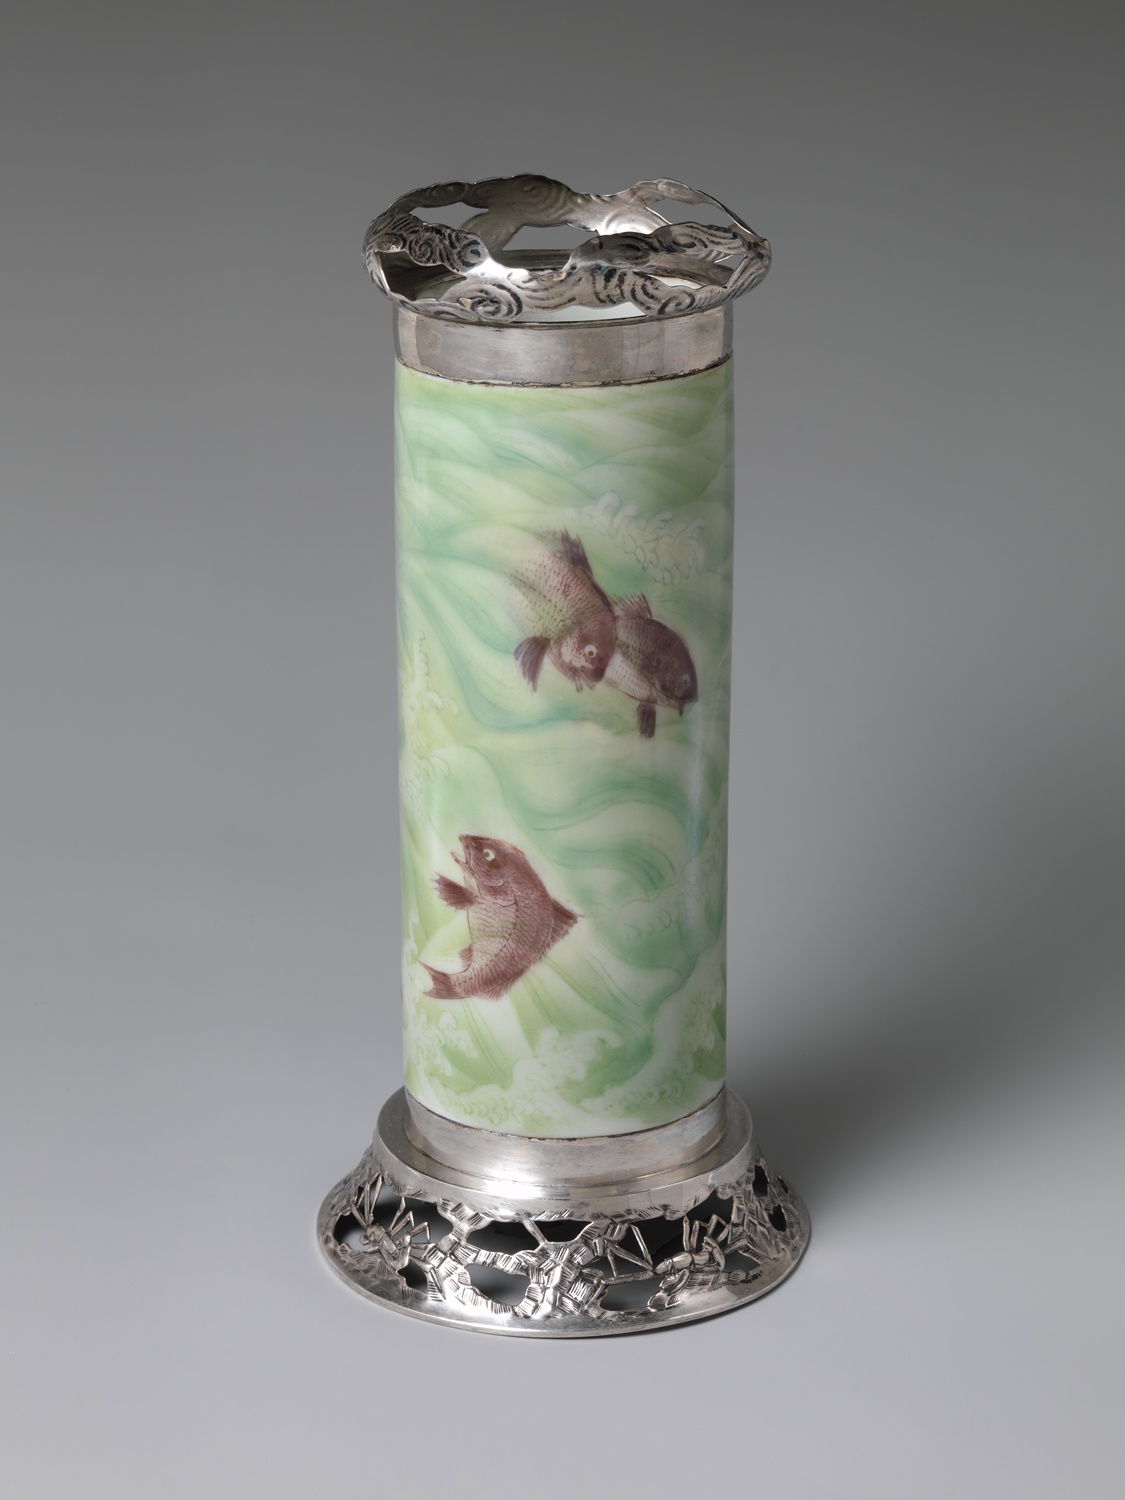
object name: vase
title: Vase with Carps in Waves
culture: japanese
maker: makuzu kōzan i (miyagawa toranosuke)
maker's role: artist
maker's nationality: japanese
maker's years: 1842-1916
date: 1867-1933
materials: metal, porcelain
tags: waves